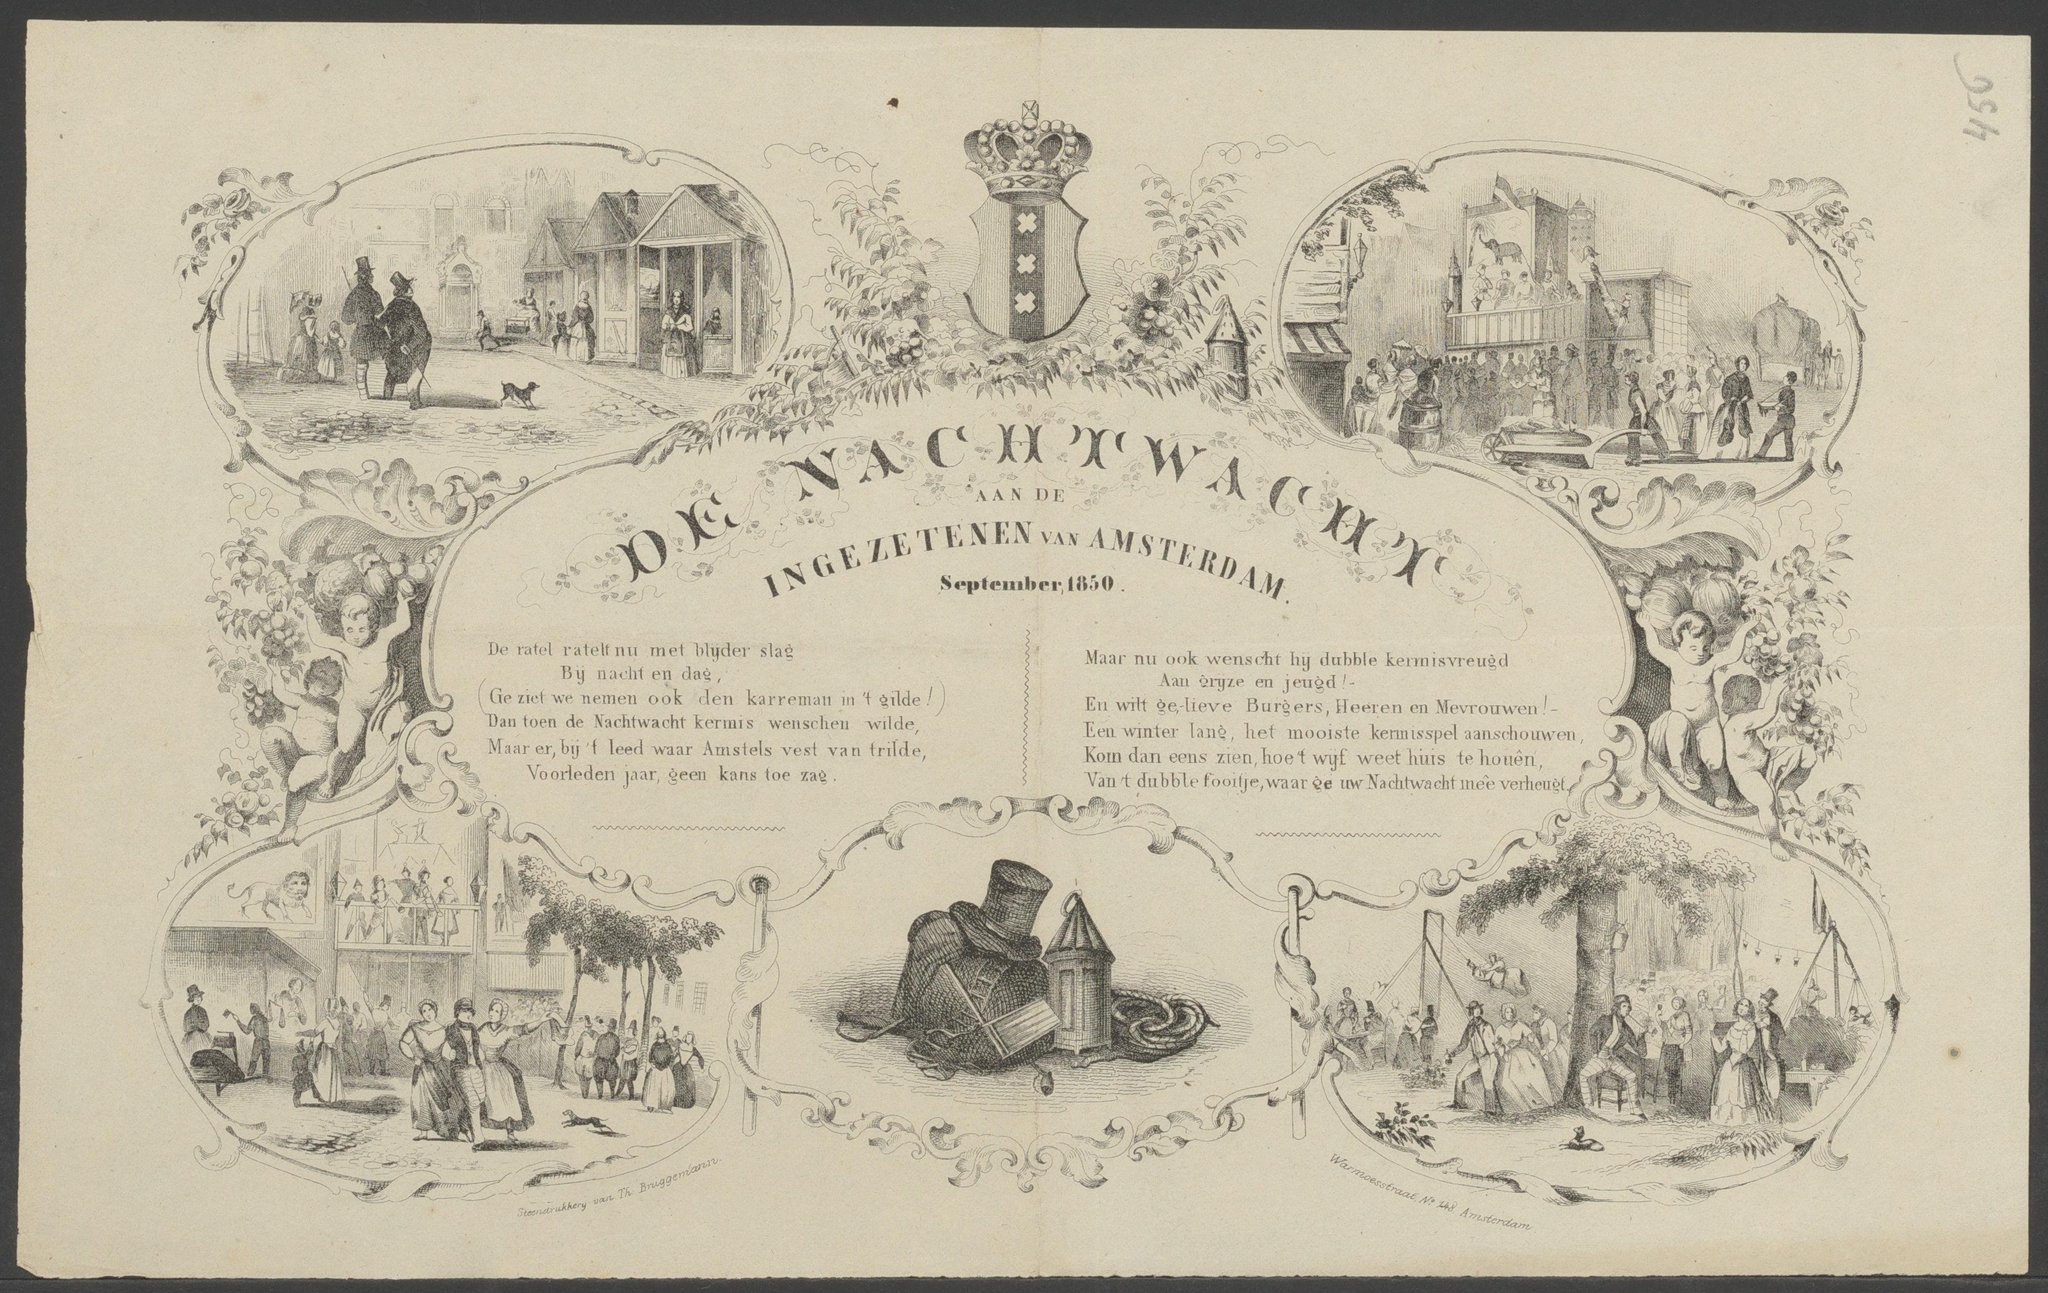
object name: print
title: Kermisprent van de Amsterdamse nachtwacht voor het jaar 1850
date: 1850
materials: paper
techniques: letterpress printing, engraving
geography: amsterdam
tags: night patrol, amsterdam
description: Kermisprent van de Amsterdamse nachtwacht, september 1850. Centraal een gedicht, aan in iedere hoek een gezicht op de stad en kermis. Onderwerpsrubrieken binnen de Atlas Zeden en Gewoonten: Zeden en gewoonten in engeren zin, Volksleven, Volksbladen, Nieuwjaars- en Kerstwenschen, Amsterdam.